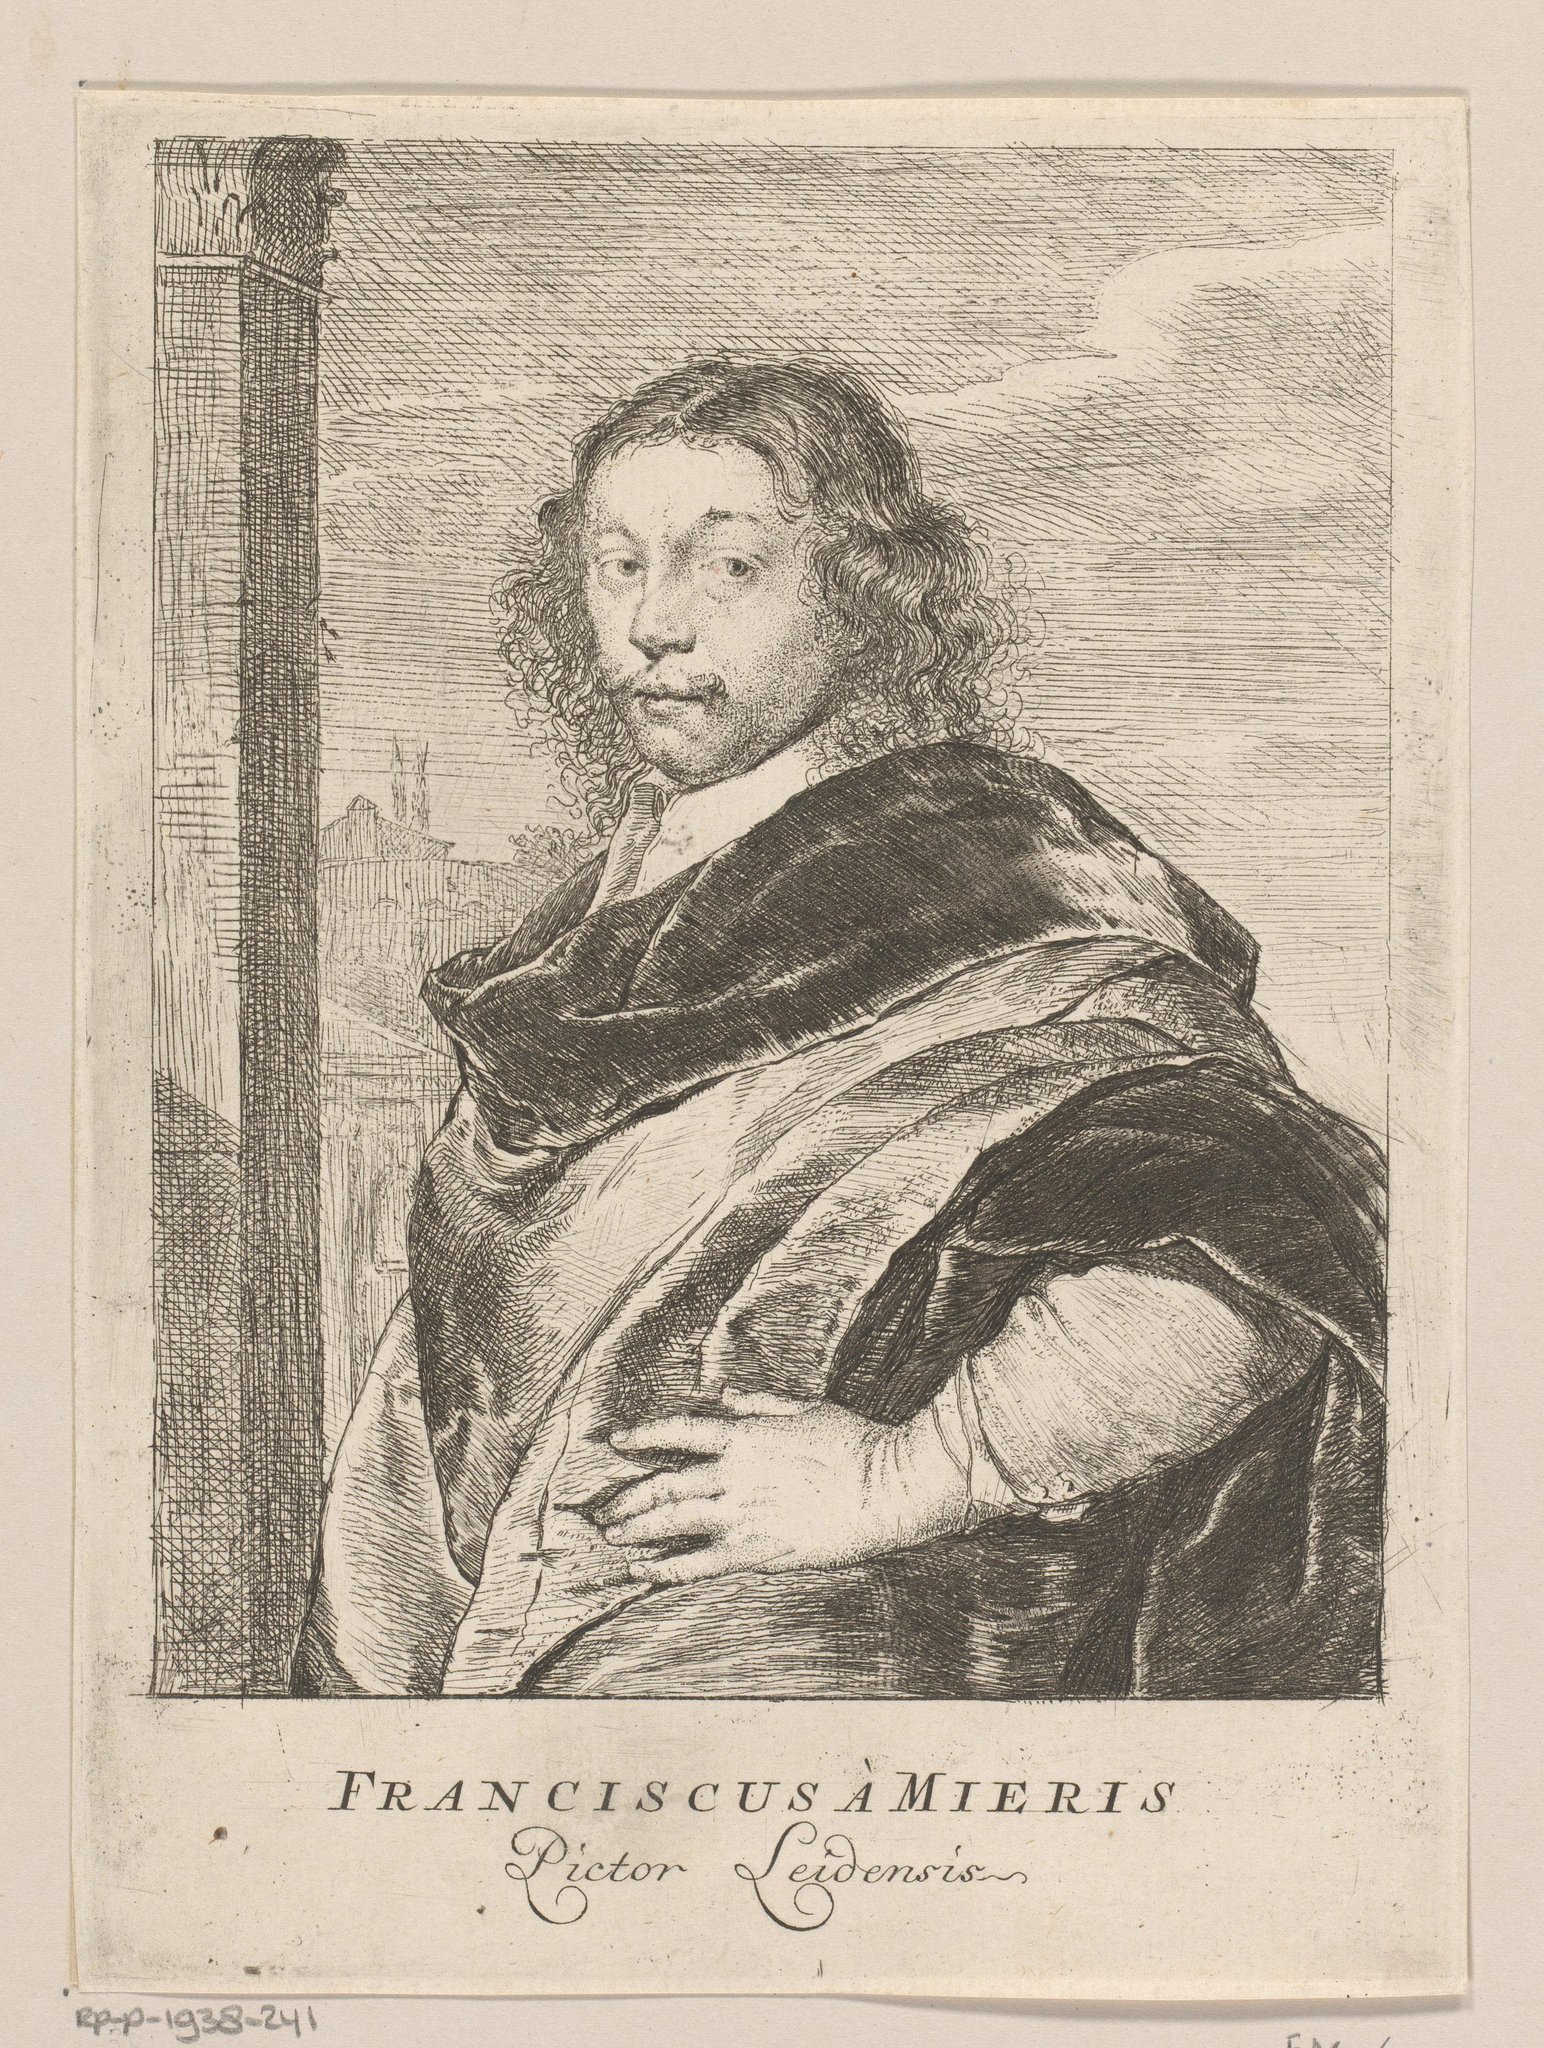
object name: print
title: Franciscus à Mieris Pictor Leidensis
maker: carel de moor (ii)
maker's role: draughtsman, painter, print maker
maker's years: 1655-1738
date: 1672-1738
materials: paper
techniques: etching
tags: frans van mieris (i), historical persons, portrait, self-portrait of painter, artist in non-work situation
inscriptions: collector's mark: Lugt 2760, collector's mark: Lugt 2228